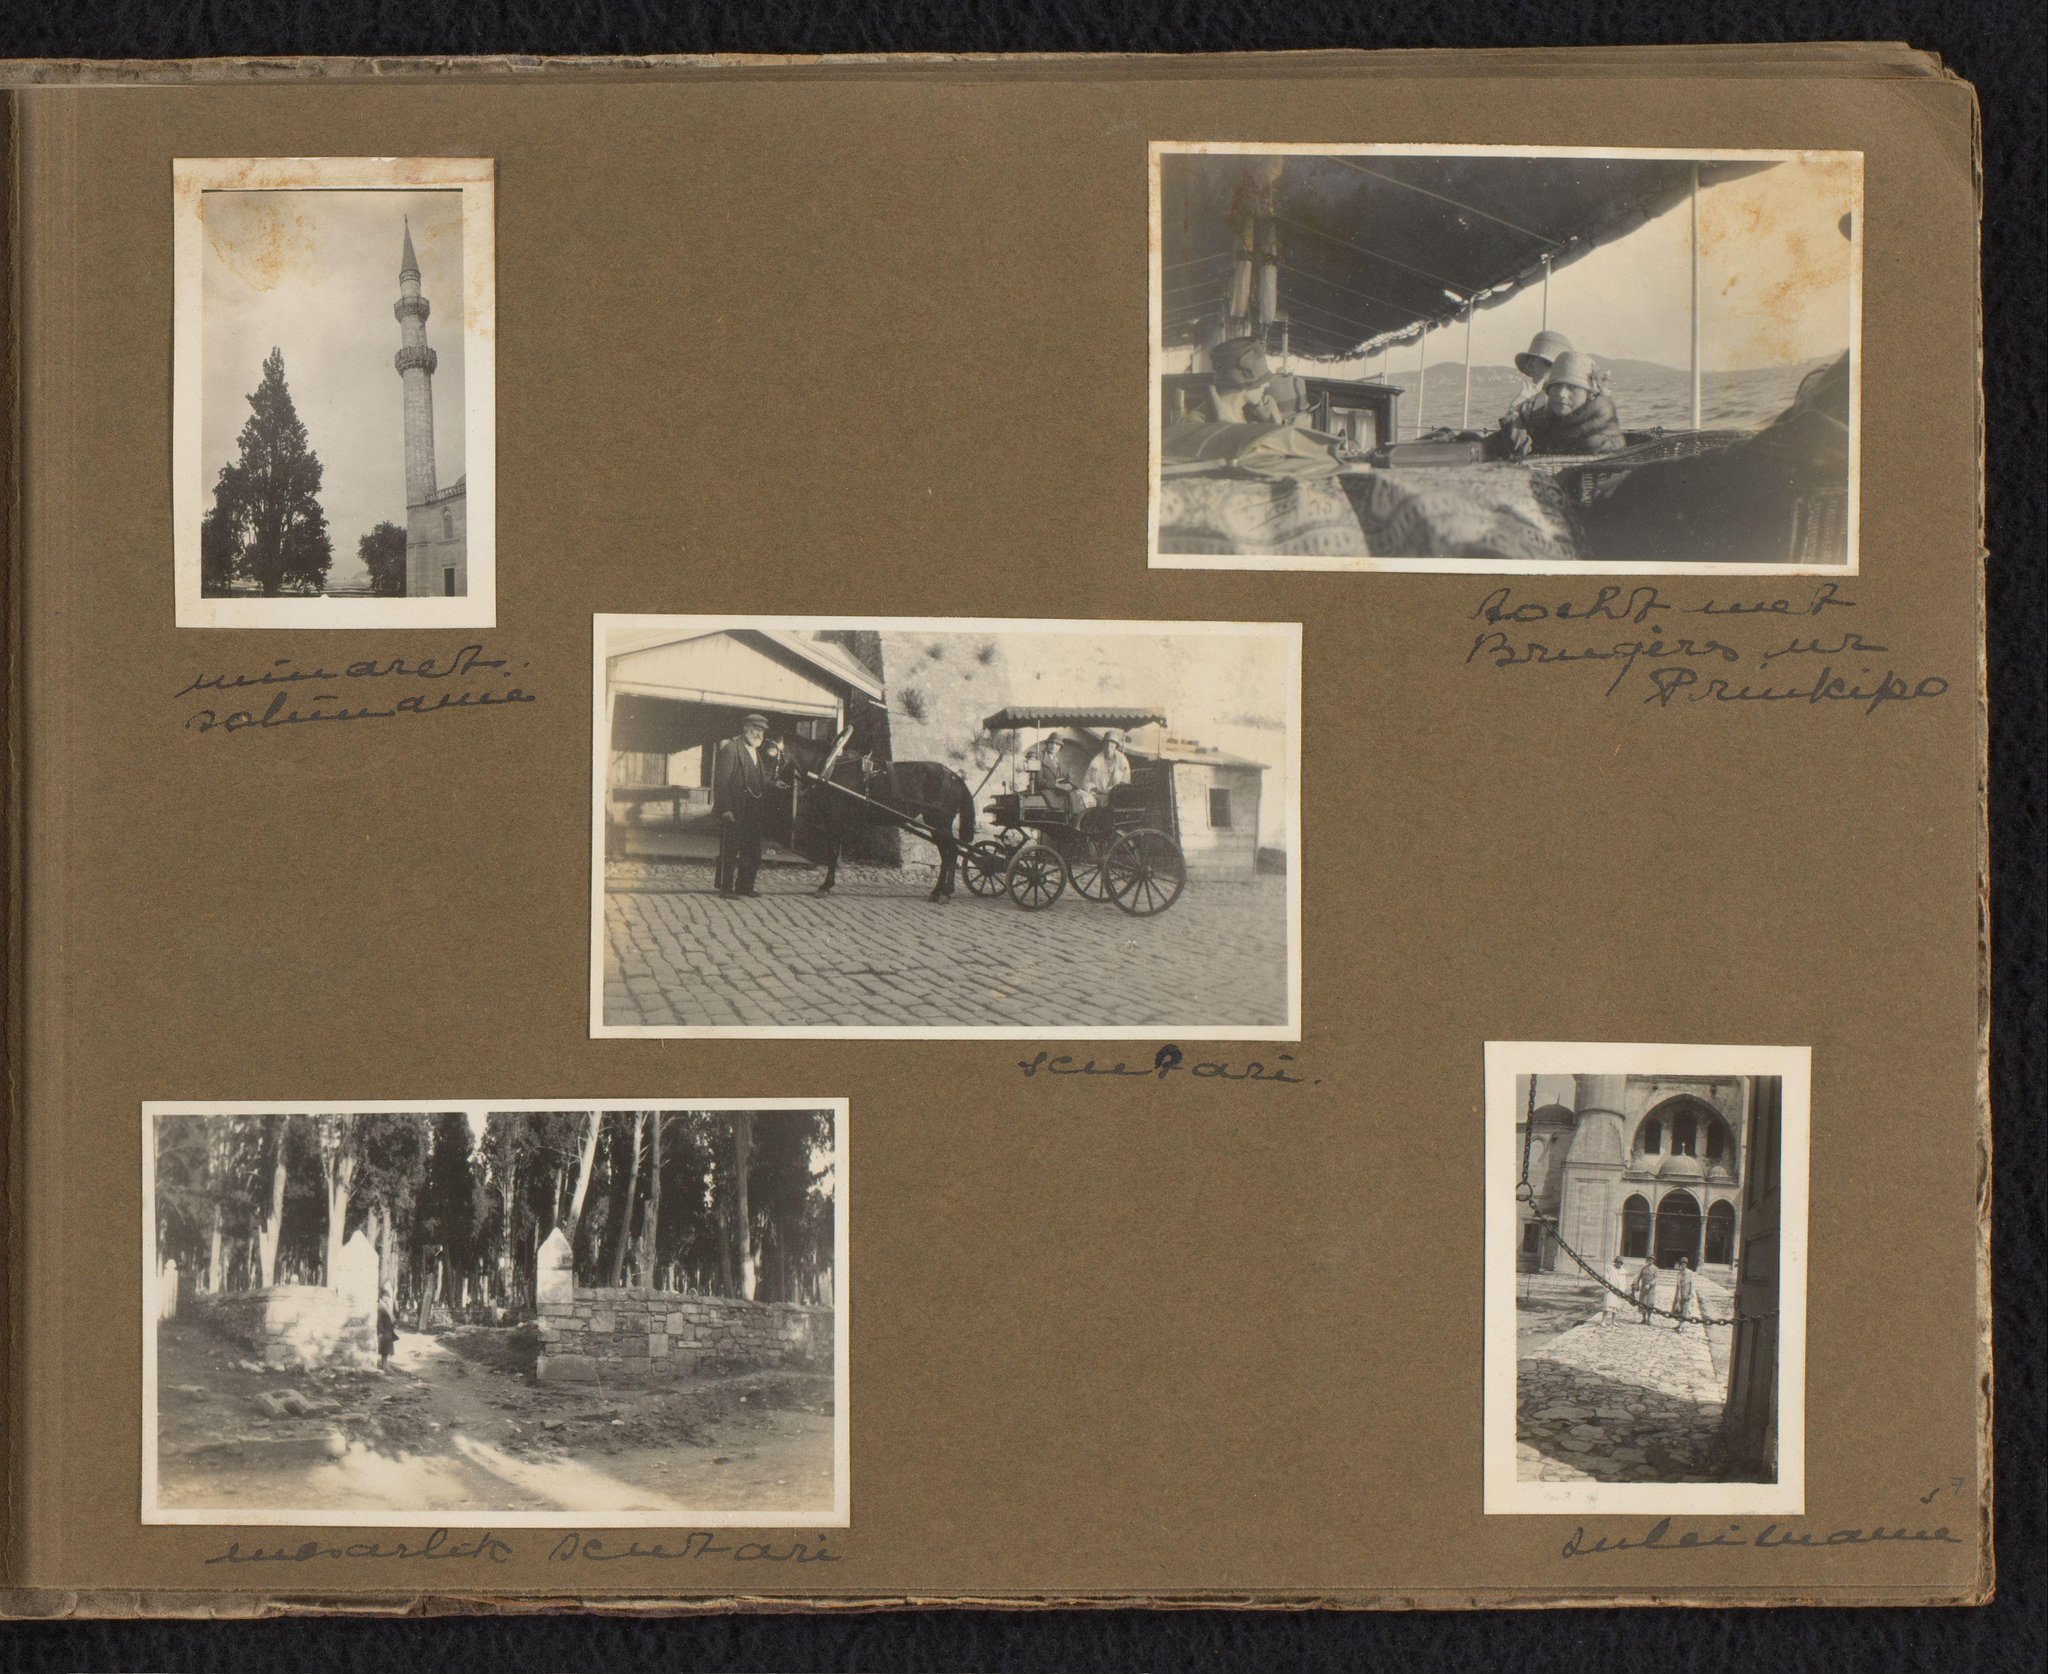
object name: album leaf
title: Vijf foto's van Istanboel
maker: carolina frederika onnen (lien/loen)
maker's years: 1896-1983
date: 1909-1926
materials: paper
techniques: gelatin silver print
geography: istanbul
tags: city-view in general; 'veduta', temple, shrine ~ islam, mohammedanism, churchyard, cemetery, street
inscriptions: inscription: ‘mesarlik scutari’, inscription: ‘minaret/ solimanie’, inscription: ‘tocht met/ Brugères nr/ Principo’, inscription: ‘suleimanie’, inscription: ‘Scutari’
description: Deze foto's maken deel uit van een album.